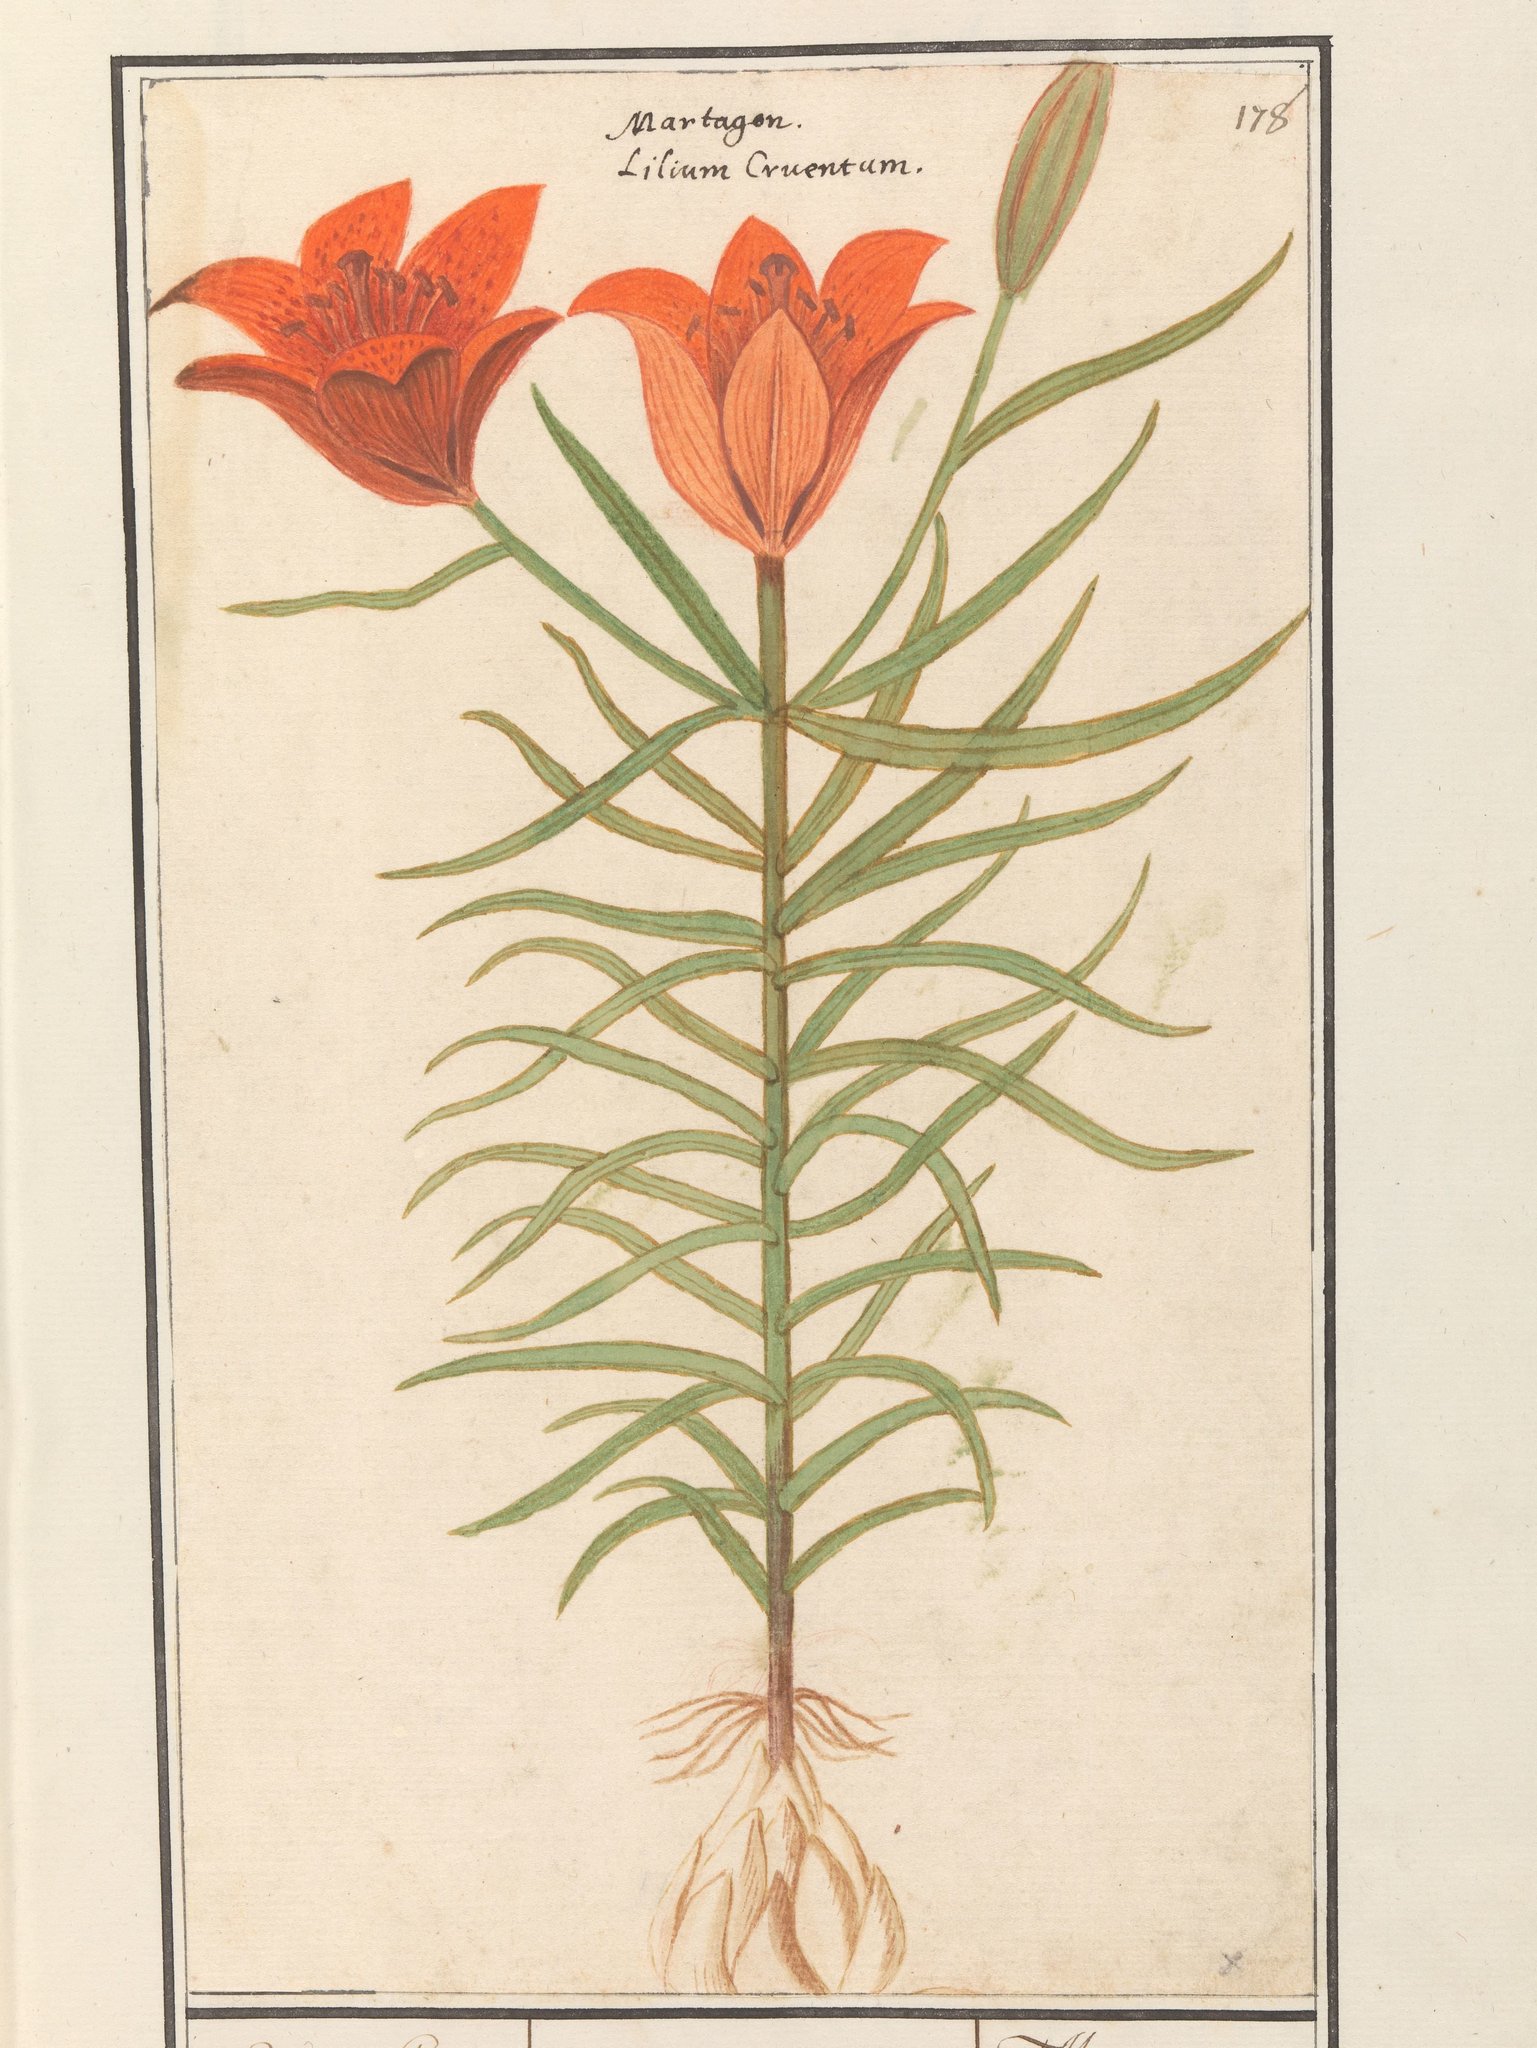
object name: drawing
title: Roode Lelie / Martagon lilium Cruentum / Martagon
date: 1596-1610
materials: chalk, paint, ink, paper, watercolor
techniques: brush, pen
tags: flowers: lily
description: Oranje lelie. Rechtsboven genummerd: 178. Bovenaan de Latijnse naam. Onderdeel van het tweede album met tekeningen van bloemen en planten. Negende van twaalf albums met tekeningen van dieren, vogels en planten bekend rond 1600, gemaakt in opdracht van keizer Rudolf II. Met toelichting in Nederlands, Latijn en Frans.